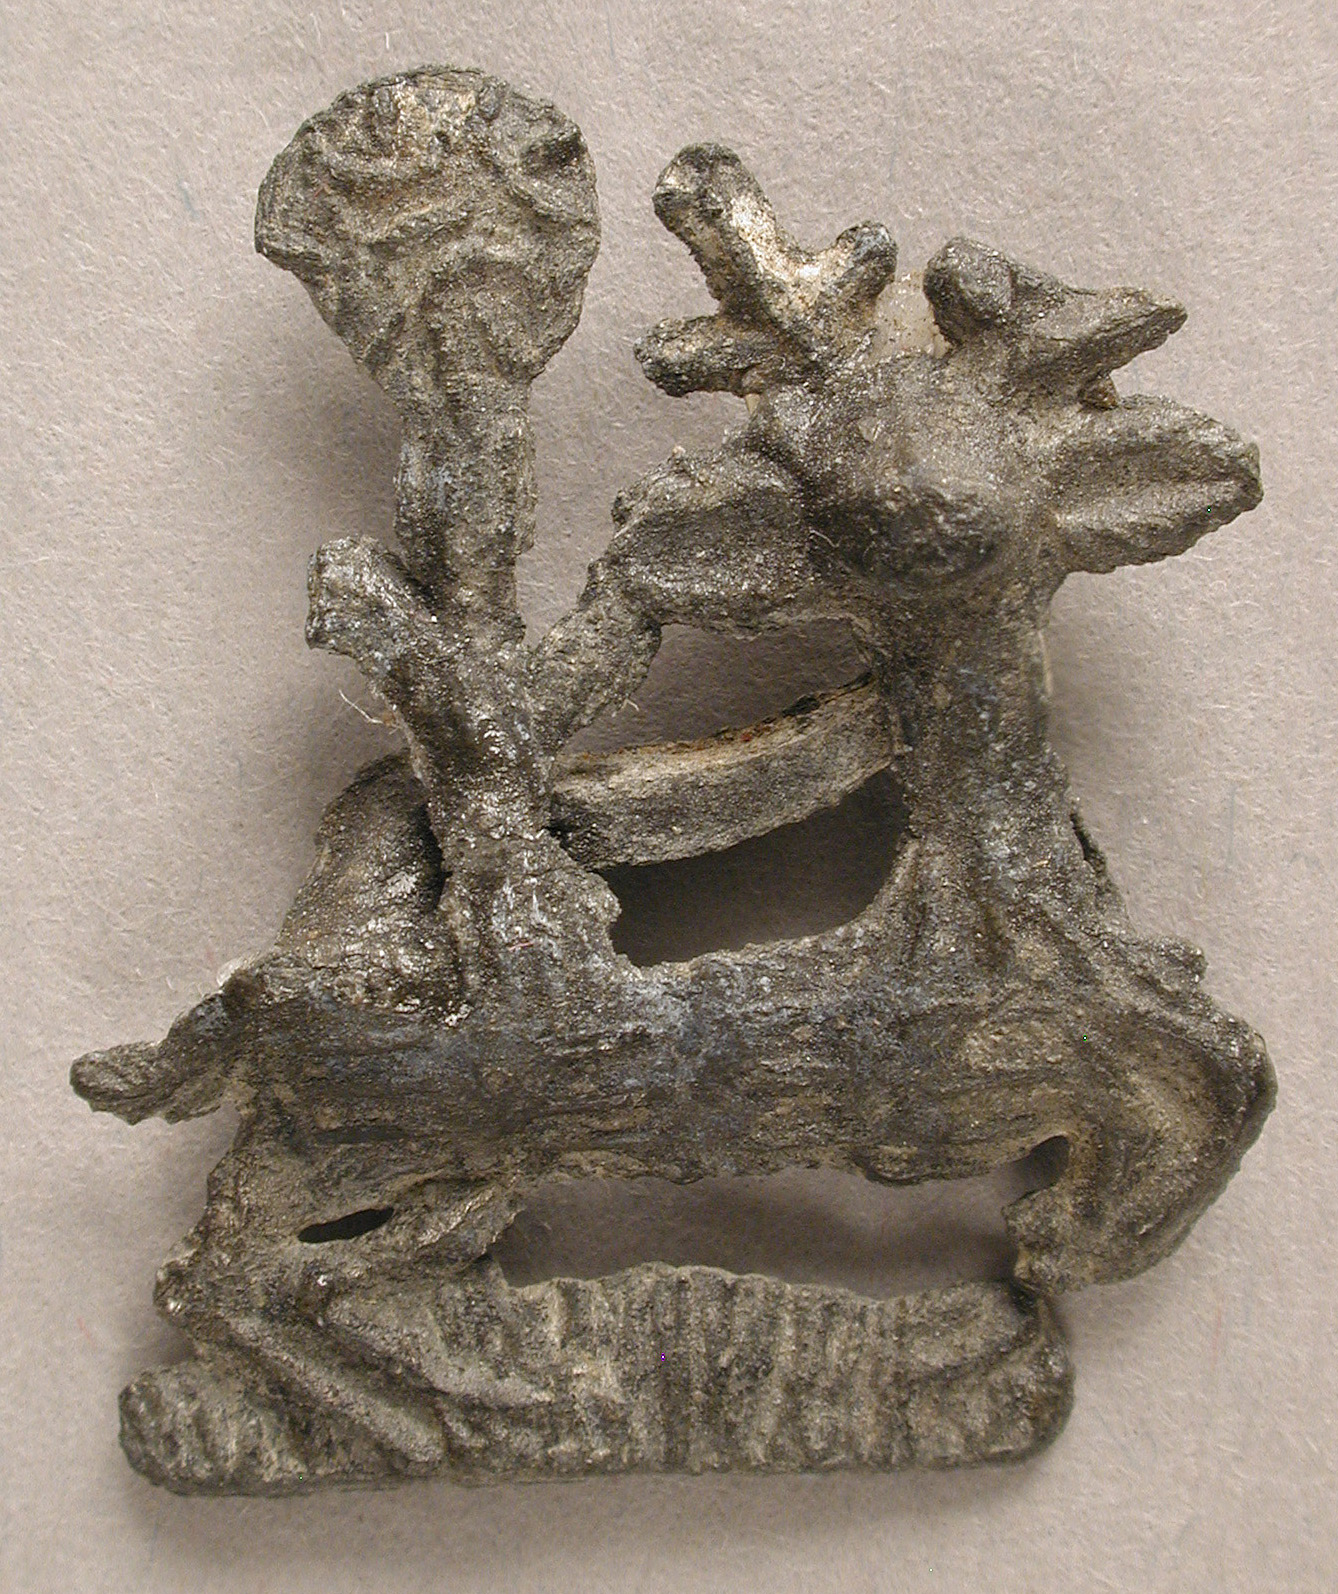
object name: pilgrim's badge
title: Badge with Richard II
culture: british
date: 1301-1400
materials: alloy, lead, tin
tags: deer